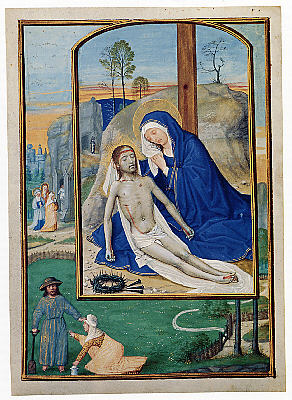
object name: leaf from manuscript, illumination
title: Pietà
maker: simon bening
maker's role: artist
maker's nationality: netherlandish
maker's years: 1483-1561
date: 1522-1523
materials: gold leaf, parchment, paint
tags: christ,virgin mary